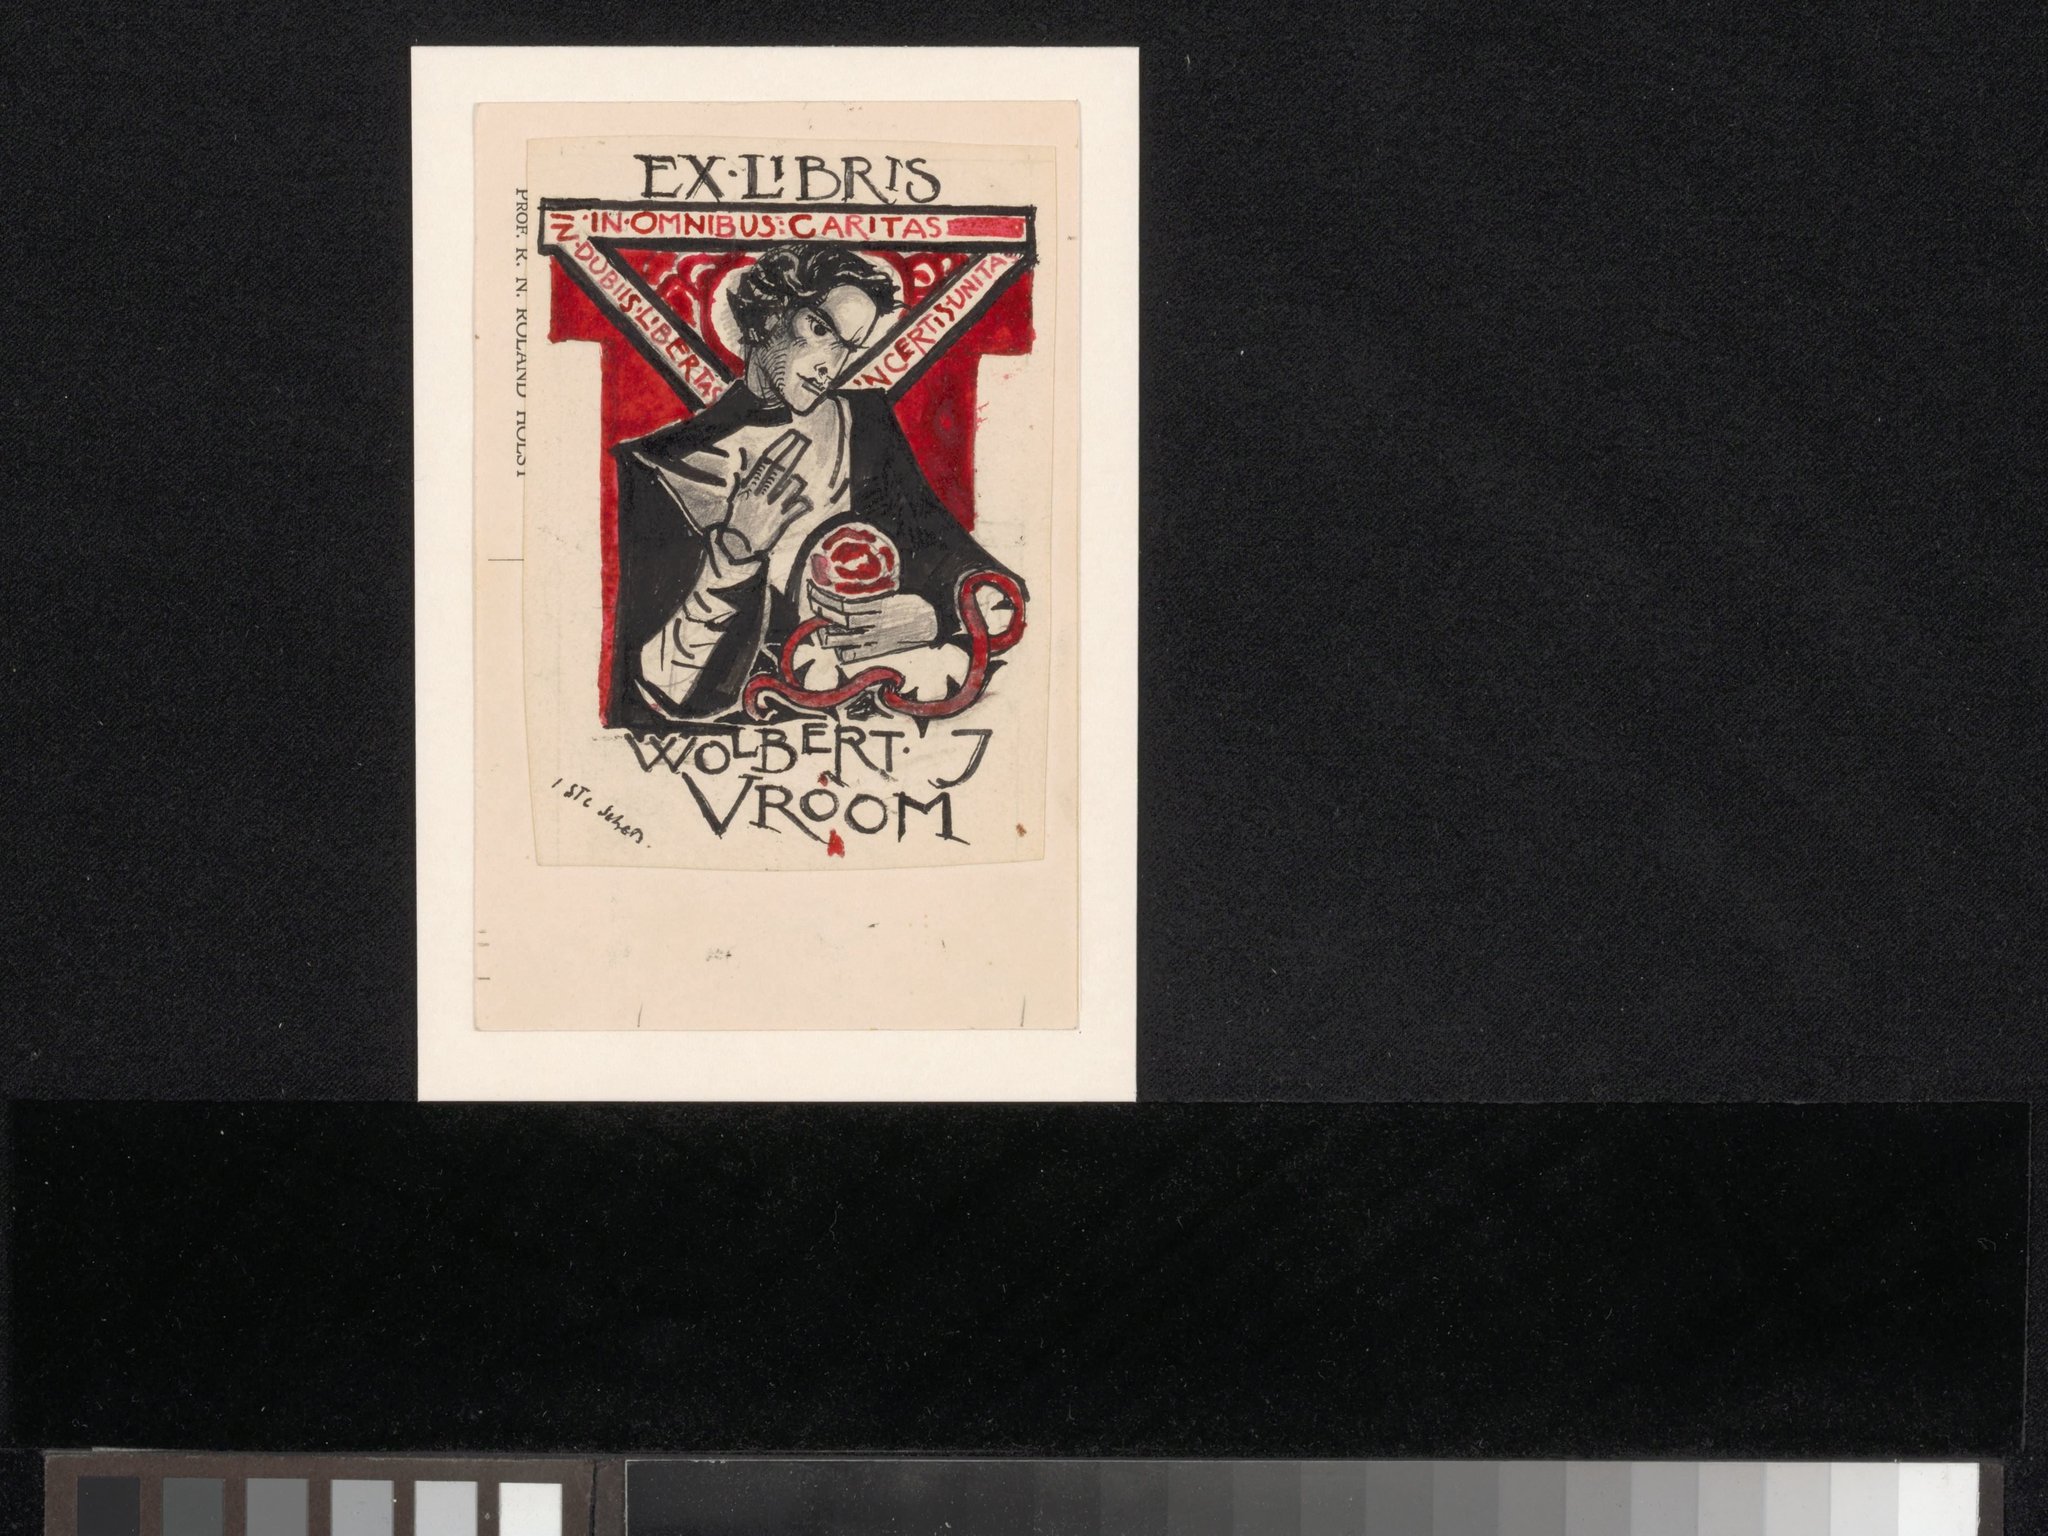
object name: drawing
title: Ex libris van Wolbert J. Vroom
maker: richard nicolaüs roland holst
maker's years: 1868-1938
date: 1924-1925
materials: cardboard, ink, pencil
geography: netherlands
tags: wolbert j. vroom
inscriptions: collector's mark: Lugt 2228